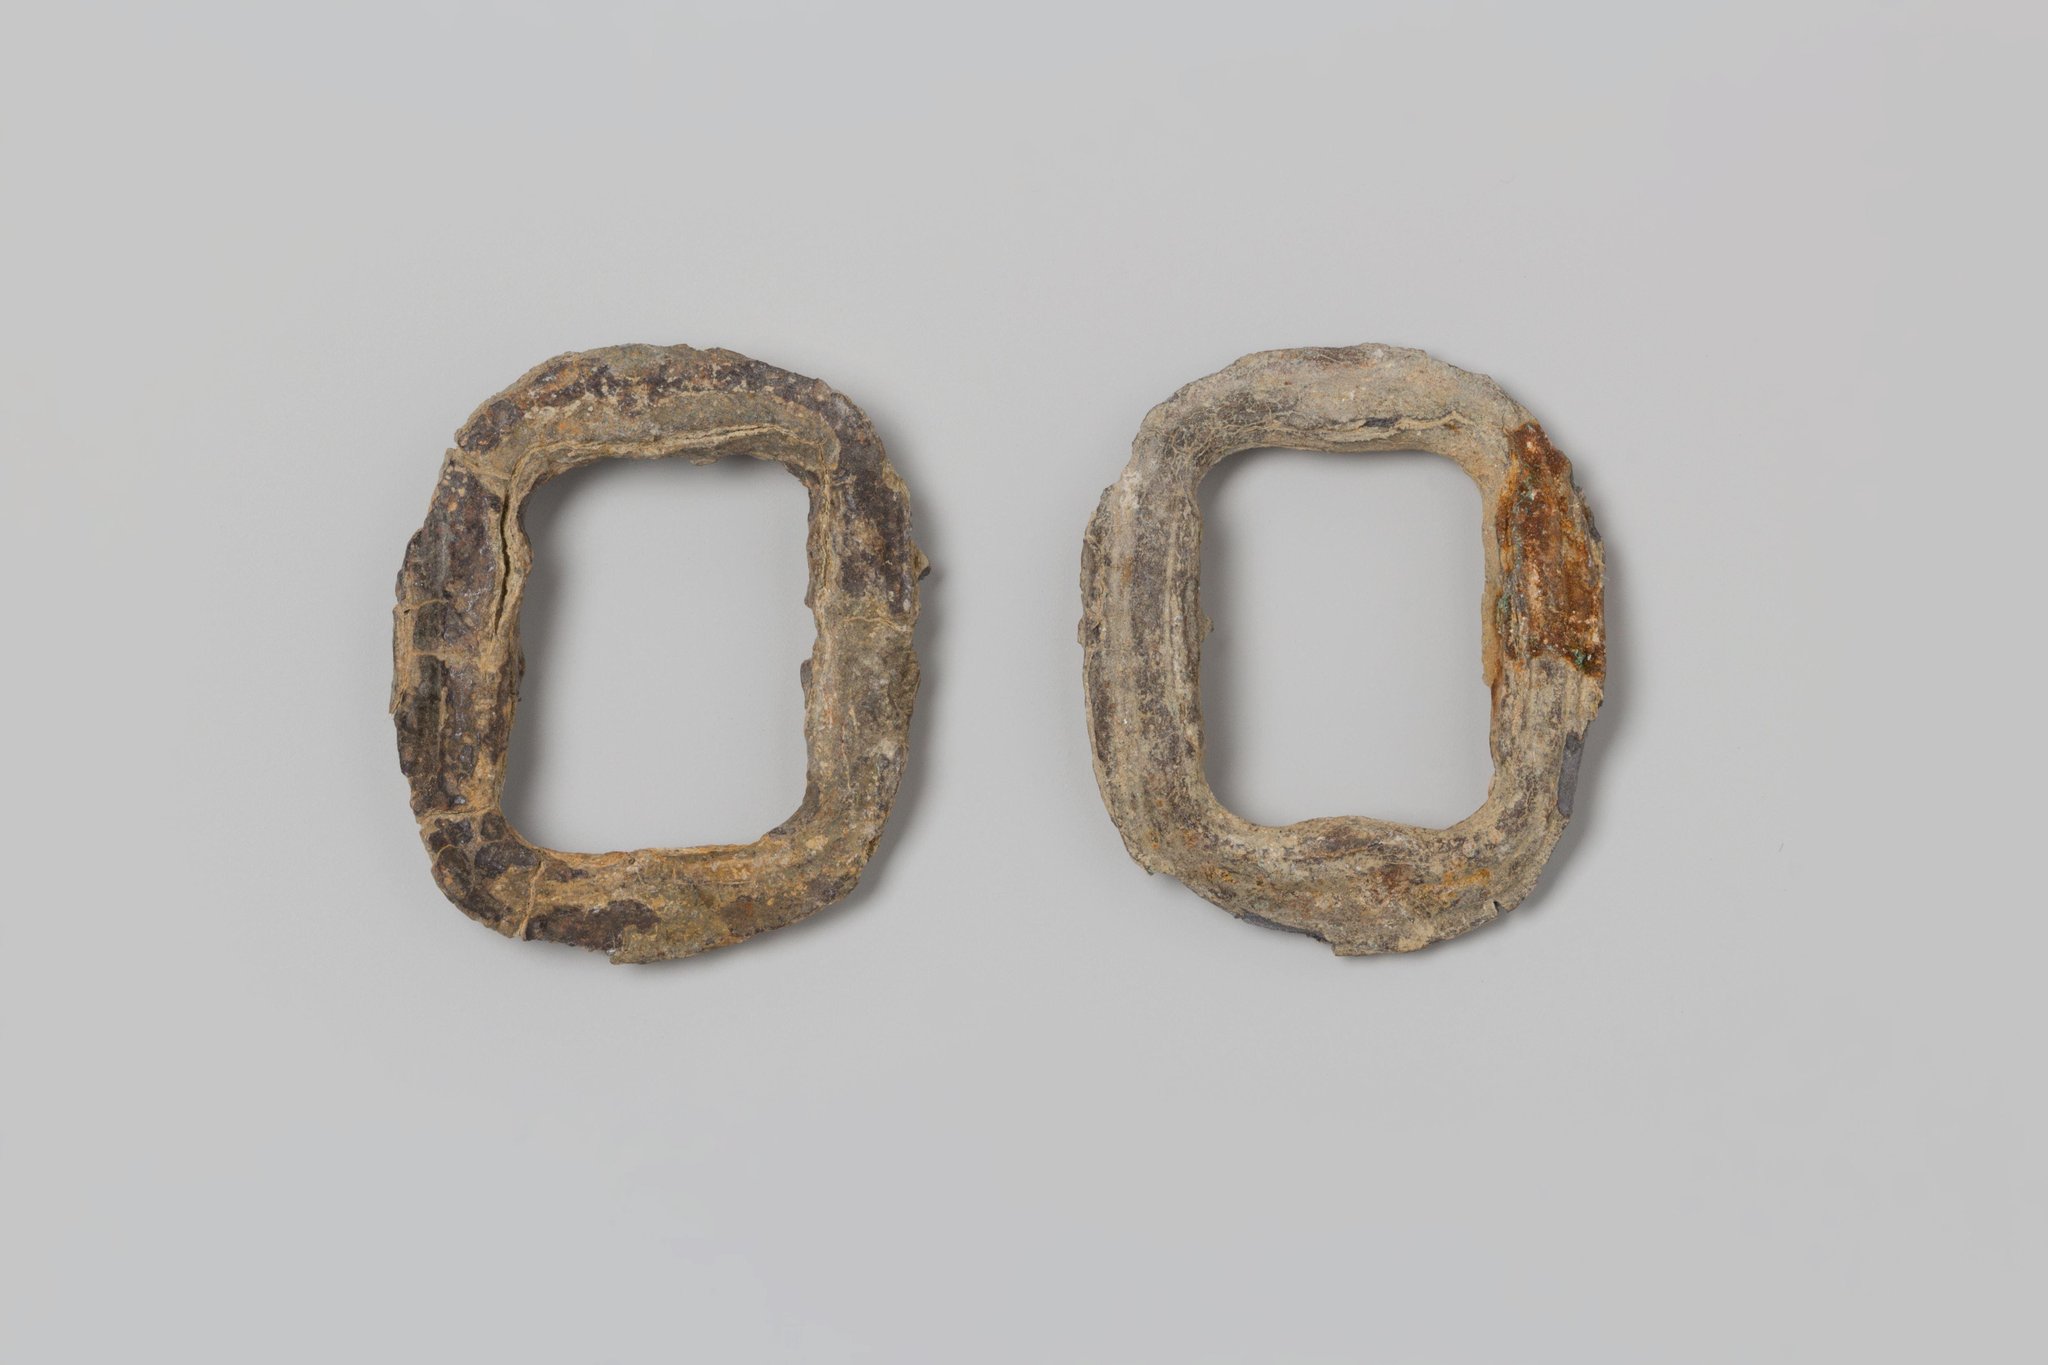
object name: shoe buckle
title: Schoengespen uit het wrak van de Oost-Indiëvaarder Hollandia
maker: Anonymous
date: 1700-1743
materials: tin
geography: netherlands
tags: verenigde oostindische compagnie, hollandia (schip), annet